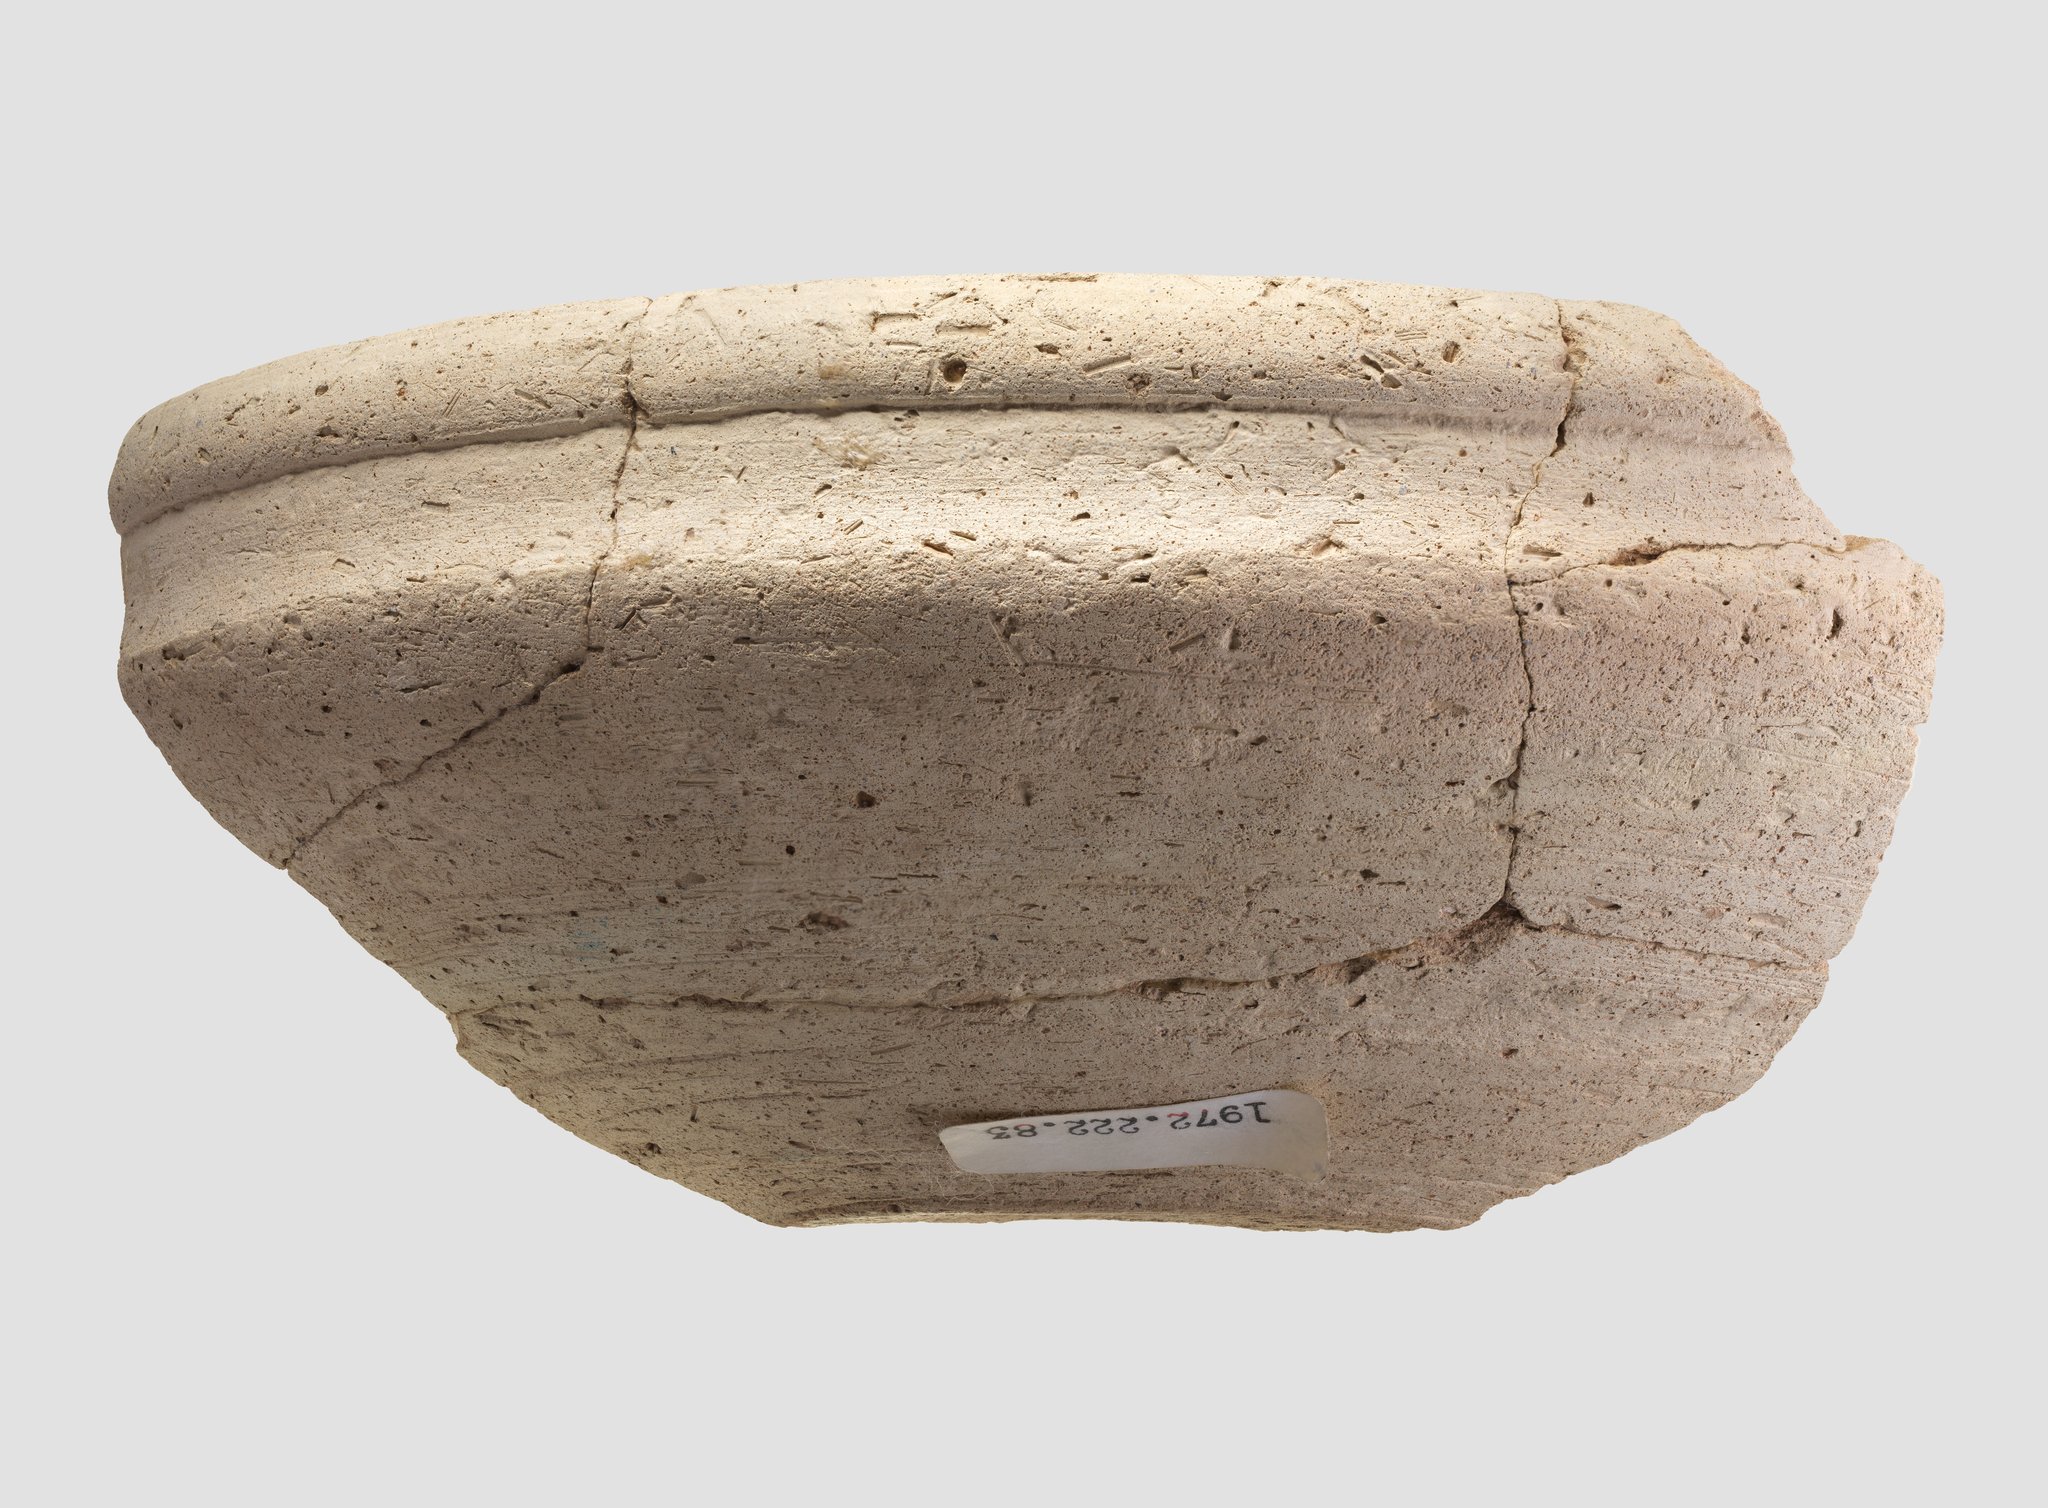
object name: bowl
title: Bowl rim sherd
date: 2333-2001 BCE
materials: ceramic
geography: mesopotamia